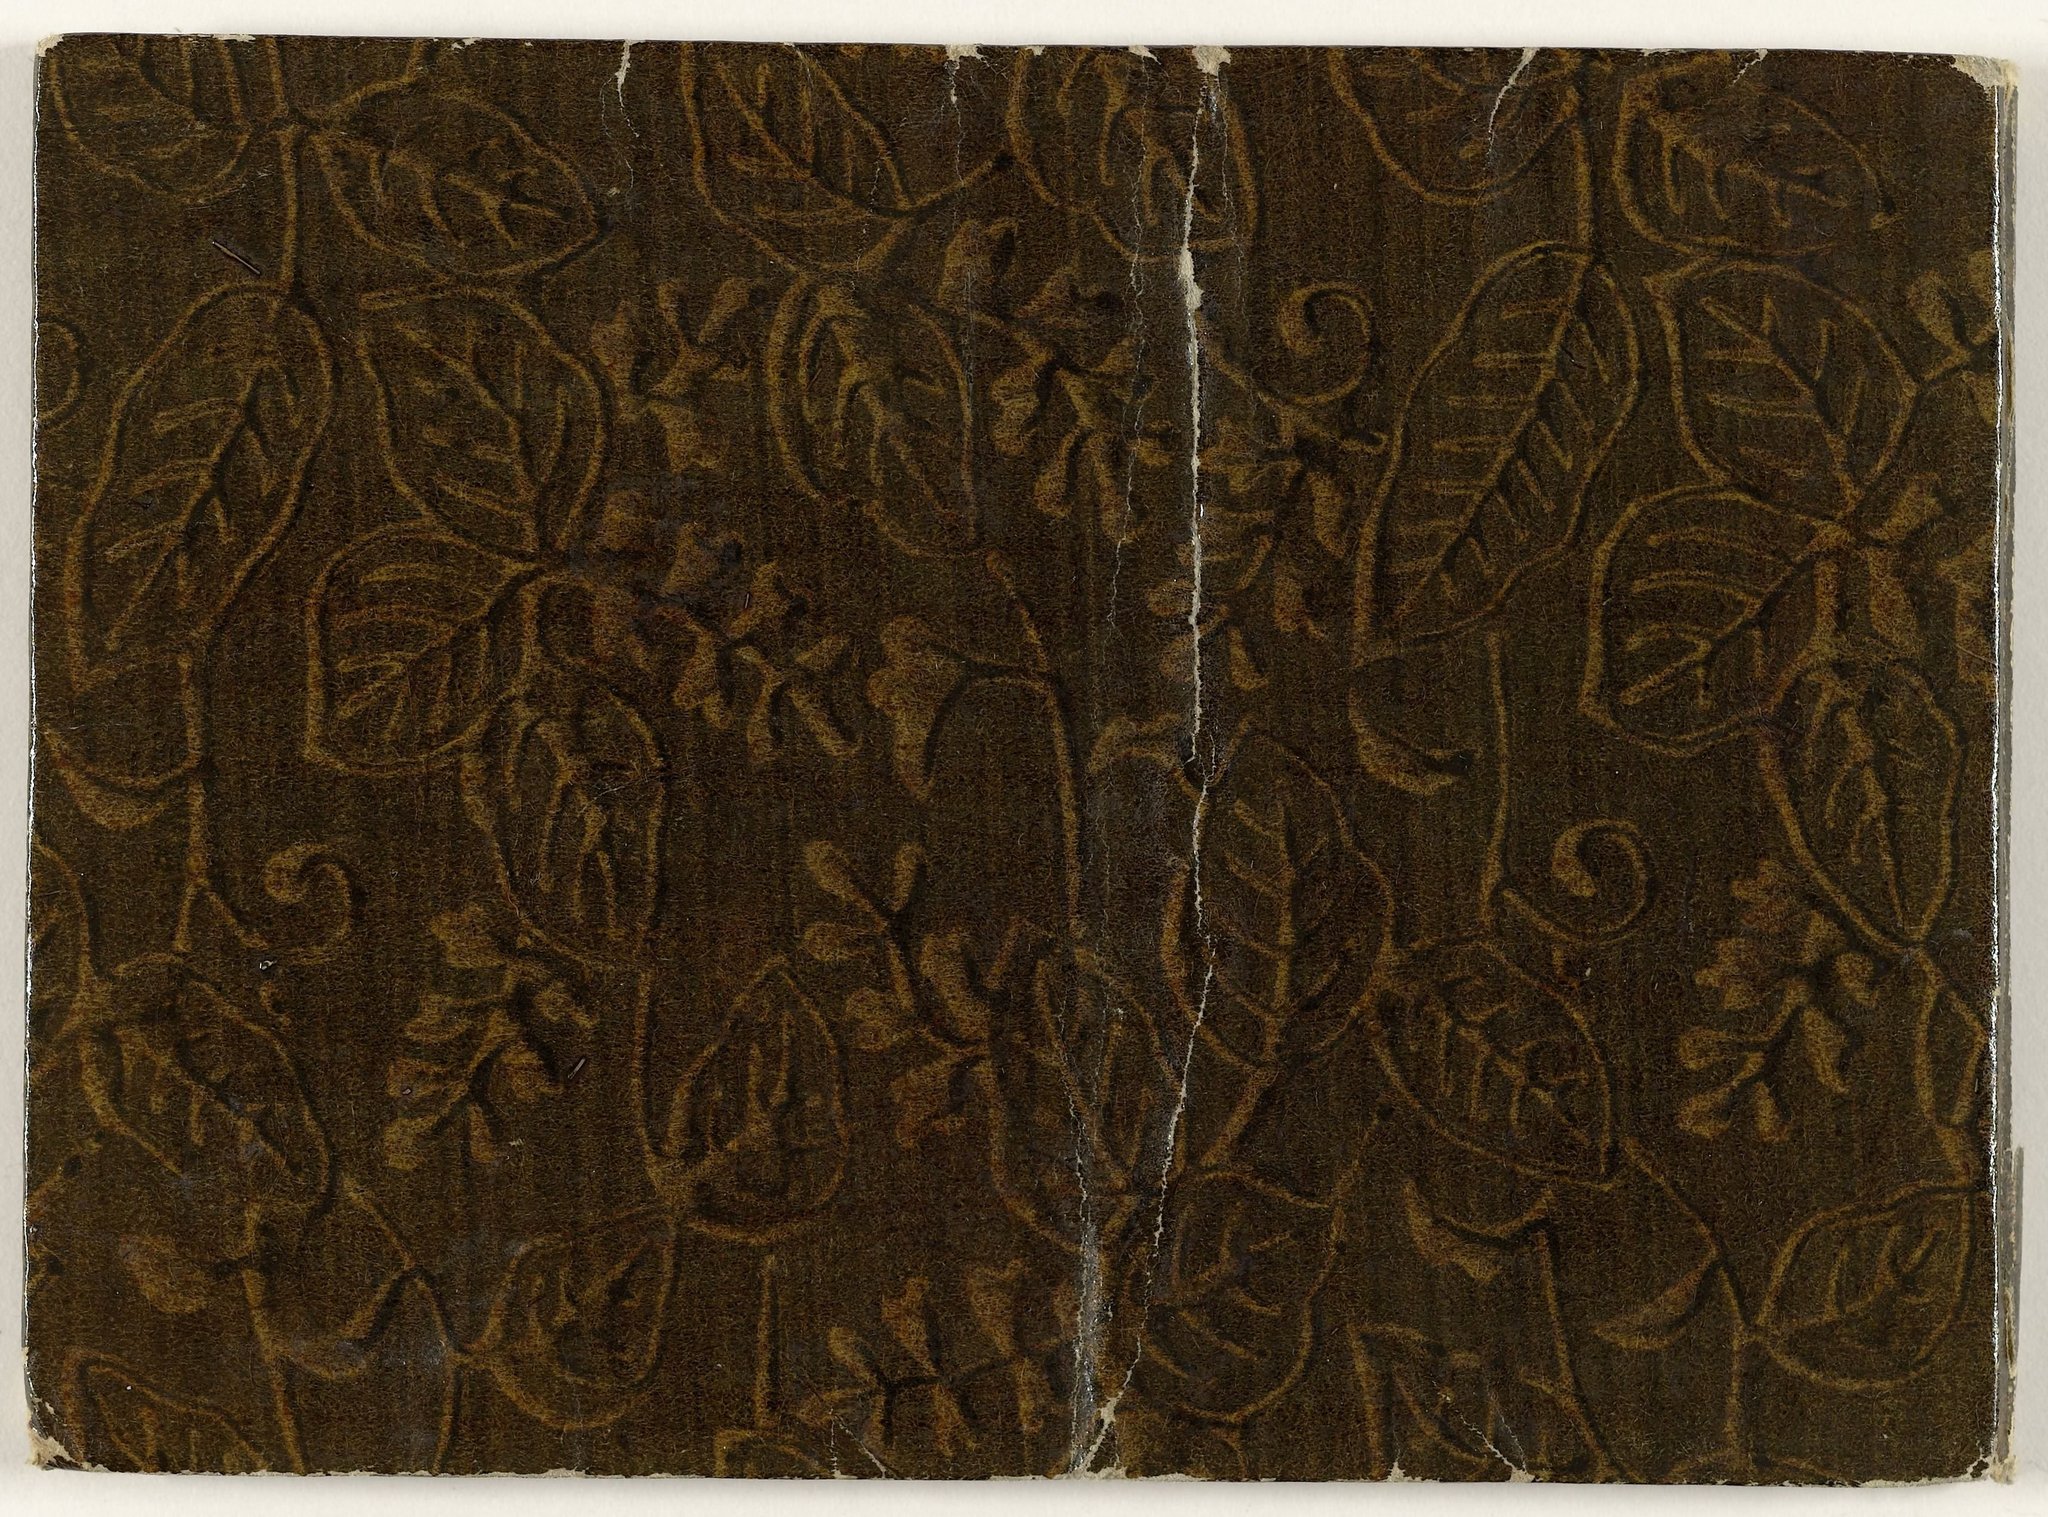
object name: book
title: Shunga serie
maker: Anonymous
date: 1800-1900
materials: gold powder, paper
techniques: blind stamped, woodcut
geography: japan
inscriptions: collector's mark: Lugt 2228